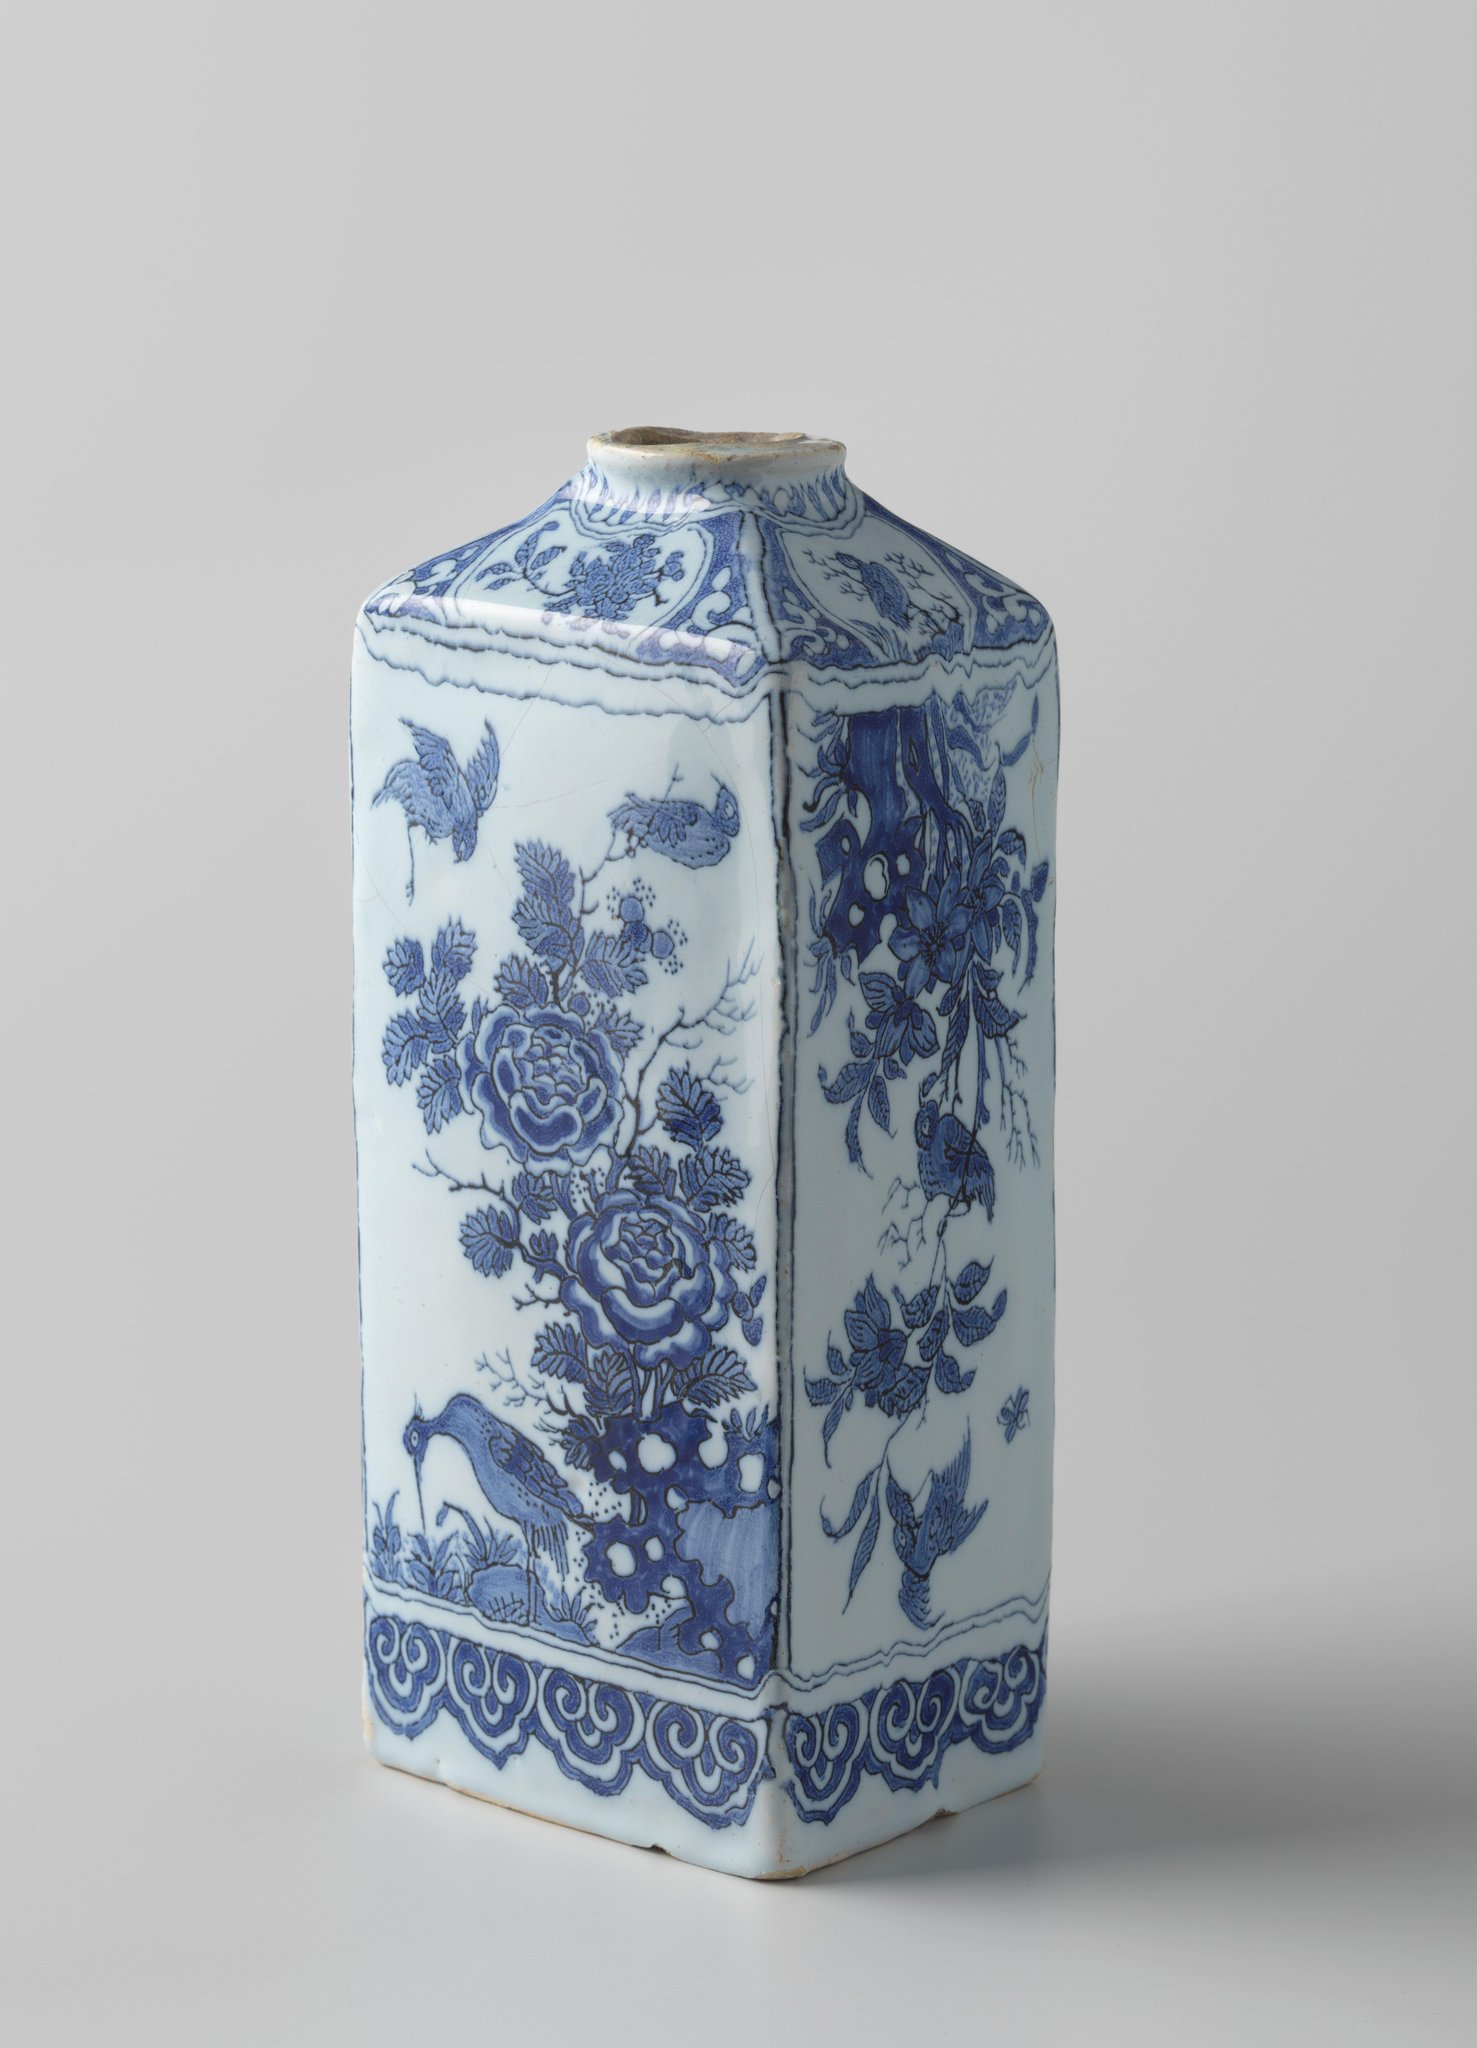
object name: tea caddy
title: Square bottle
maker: samuel van eenhoorn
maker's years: 1655-1687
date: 1675-1690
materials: earthenware, glaze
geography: delft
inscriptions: mark: ‘SVE(ineen)/ 10’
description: In the 17th century Chinese porcelain was one of the pre-eminent luxury goods displayed on the tables of the upper classes. It was also used for decoration of the interior. Reacting to the commercial success of porcelain, potters in Delft developed a very fine type of earthenware in imitation of it. Both the forms and the decoration of this earthenware – or Delftware – were often directly inspired by Chinese examples.